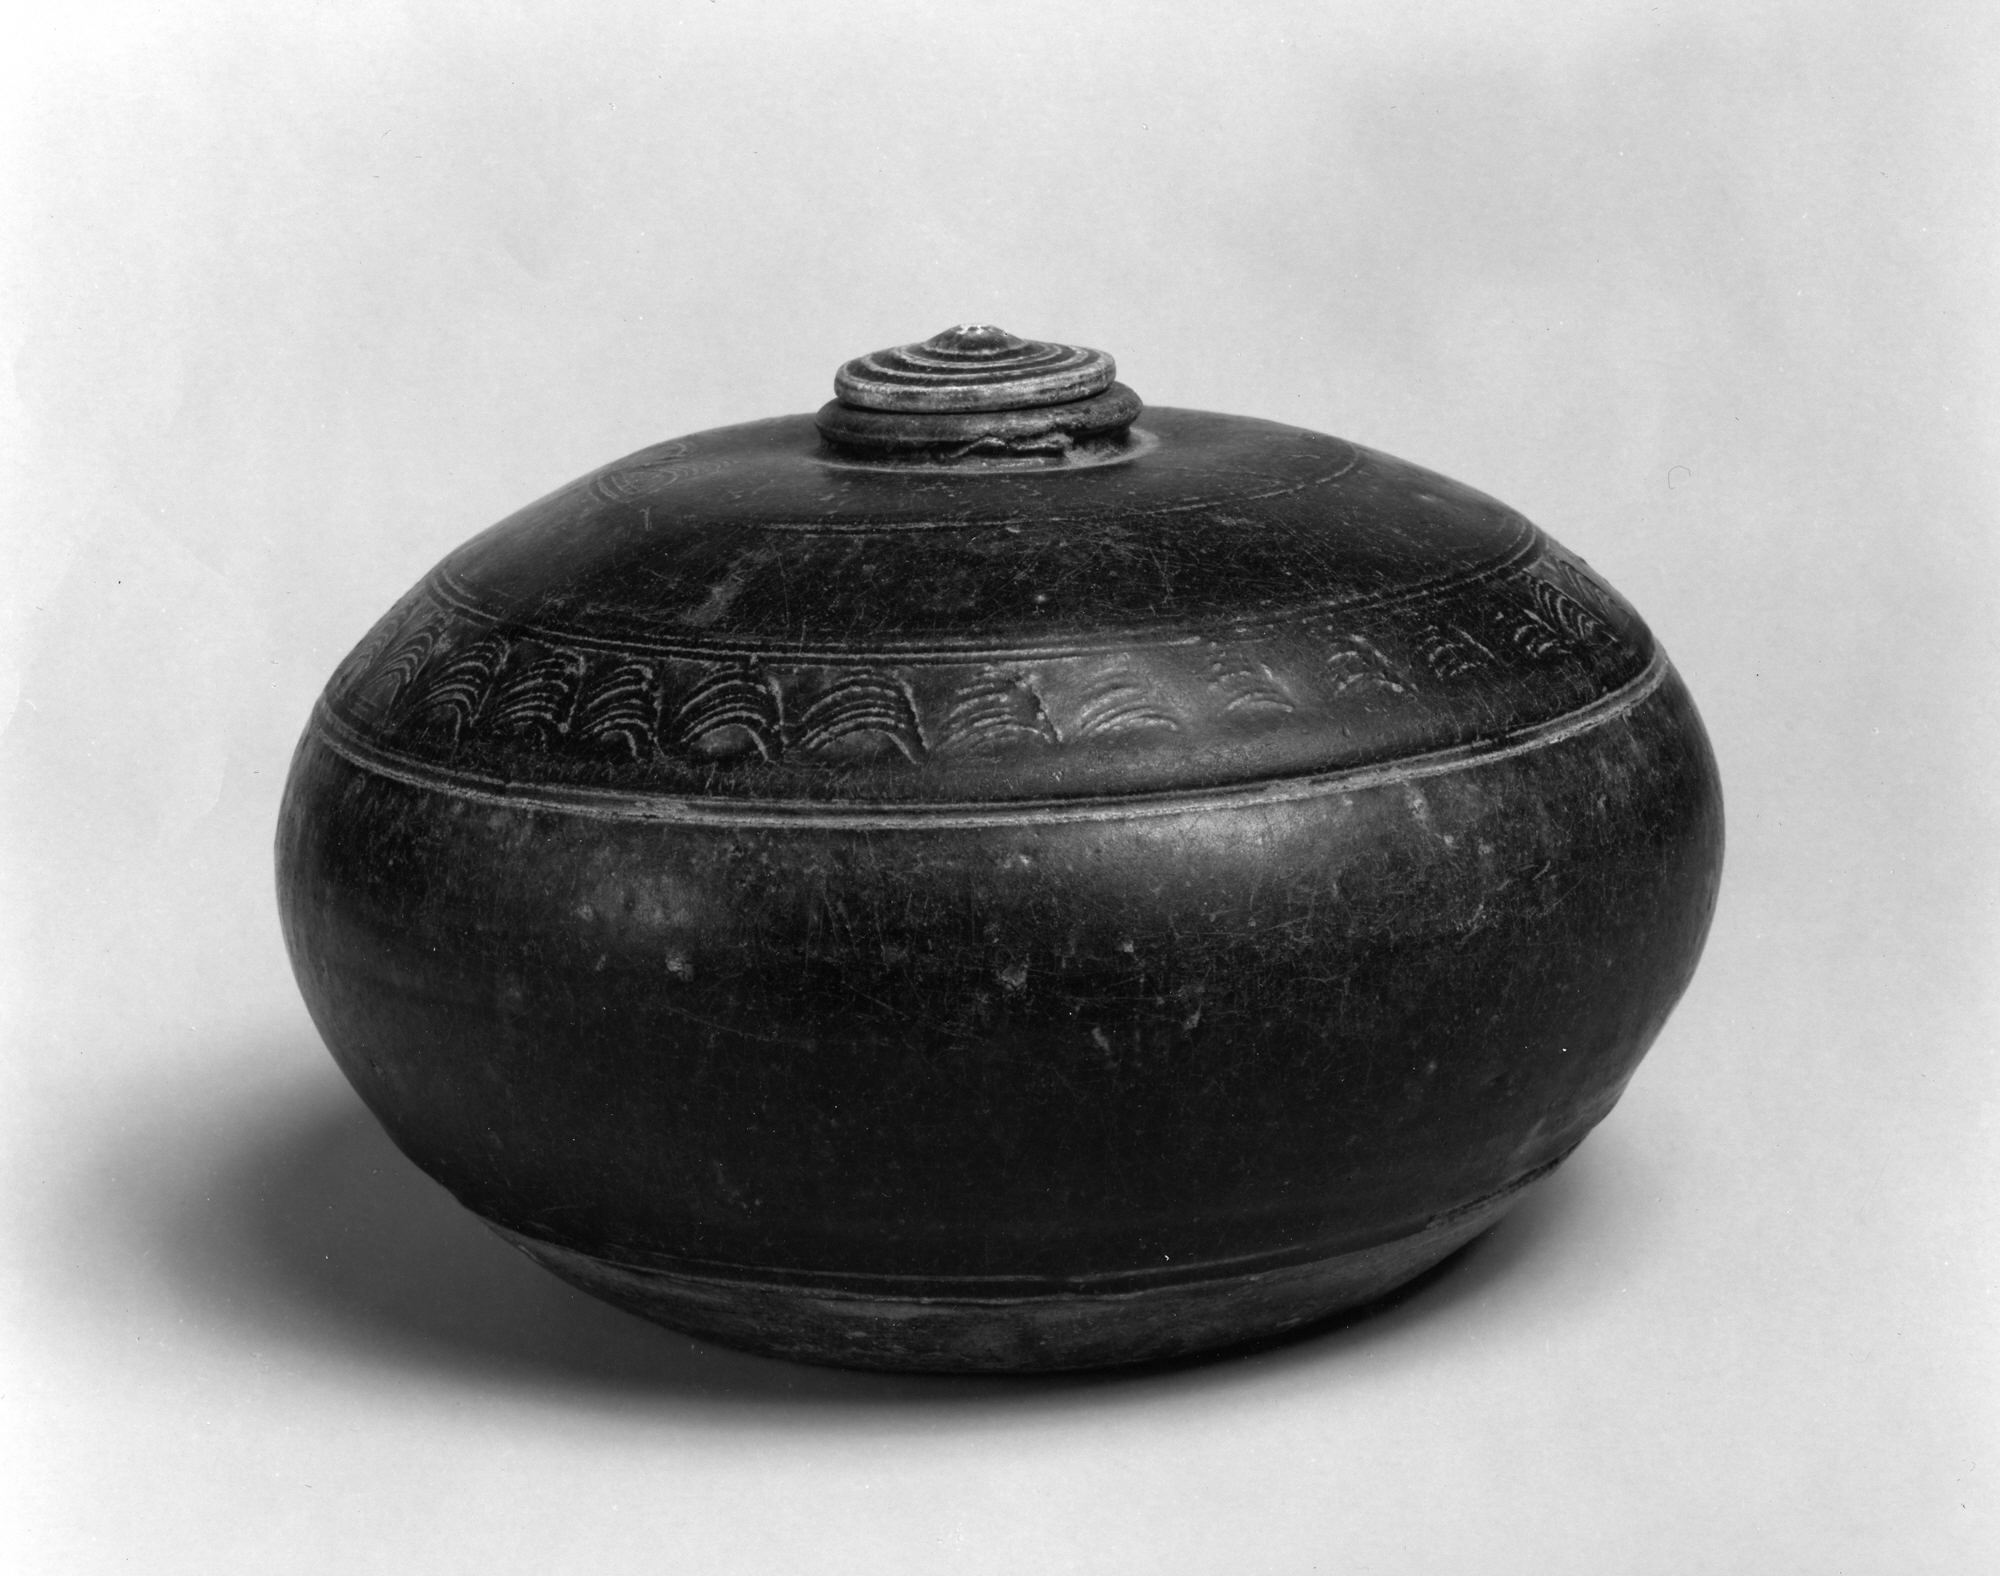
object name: vase with cover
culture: thai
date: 1067-1200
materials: stoneware